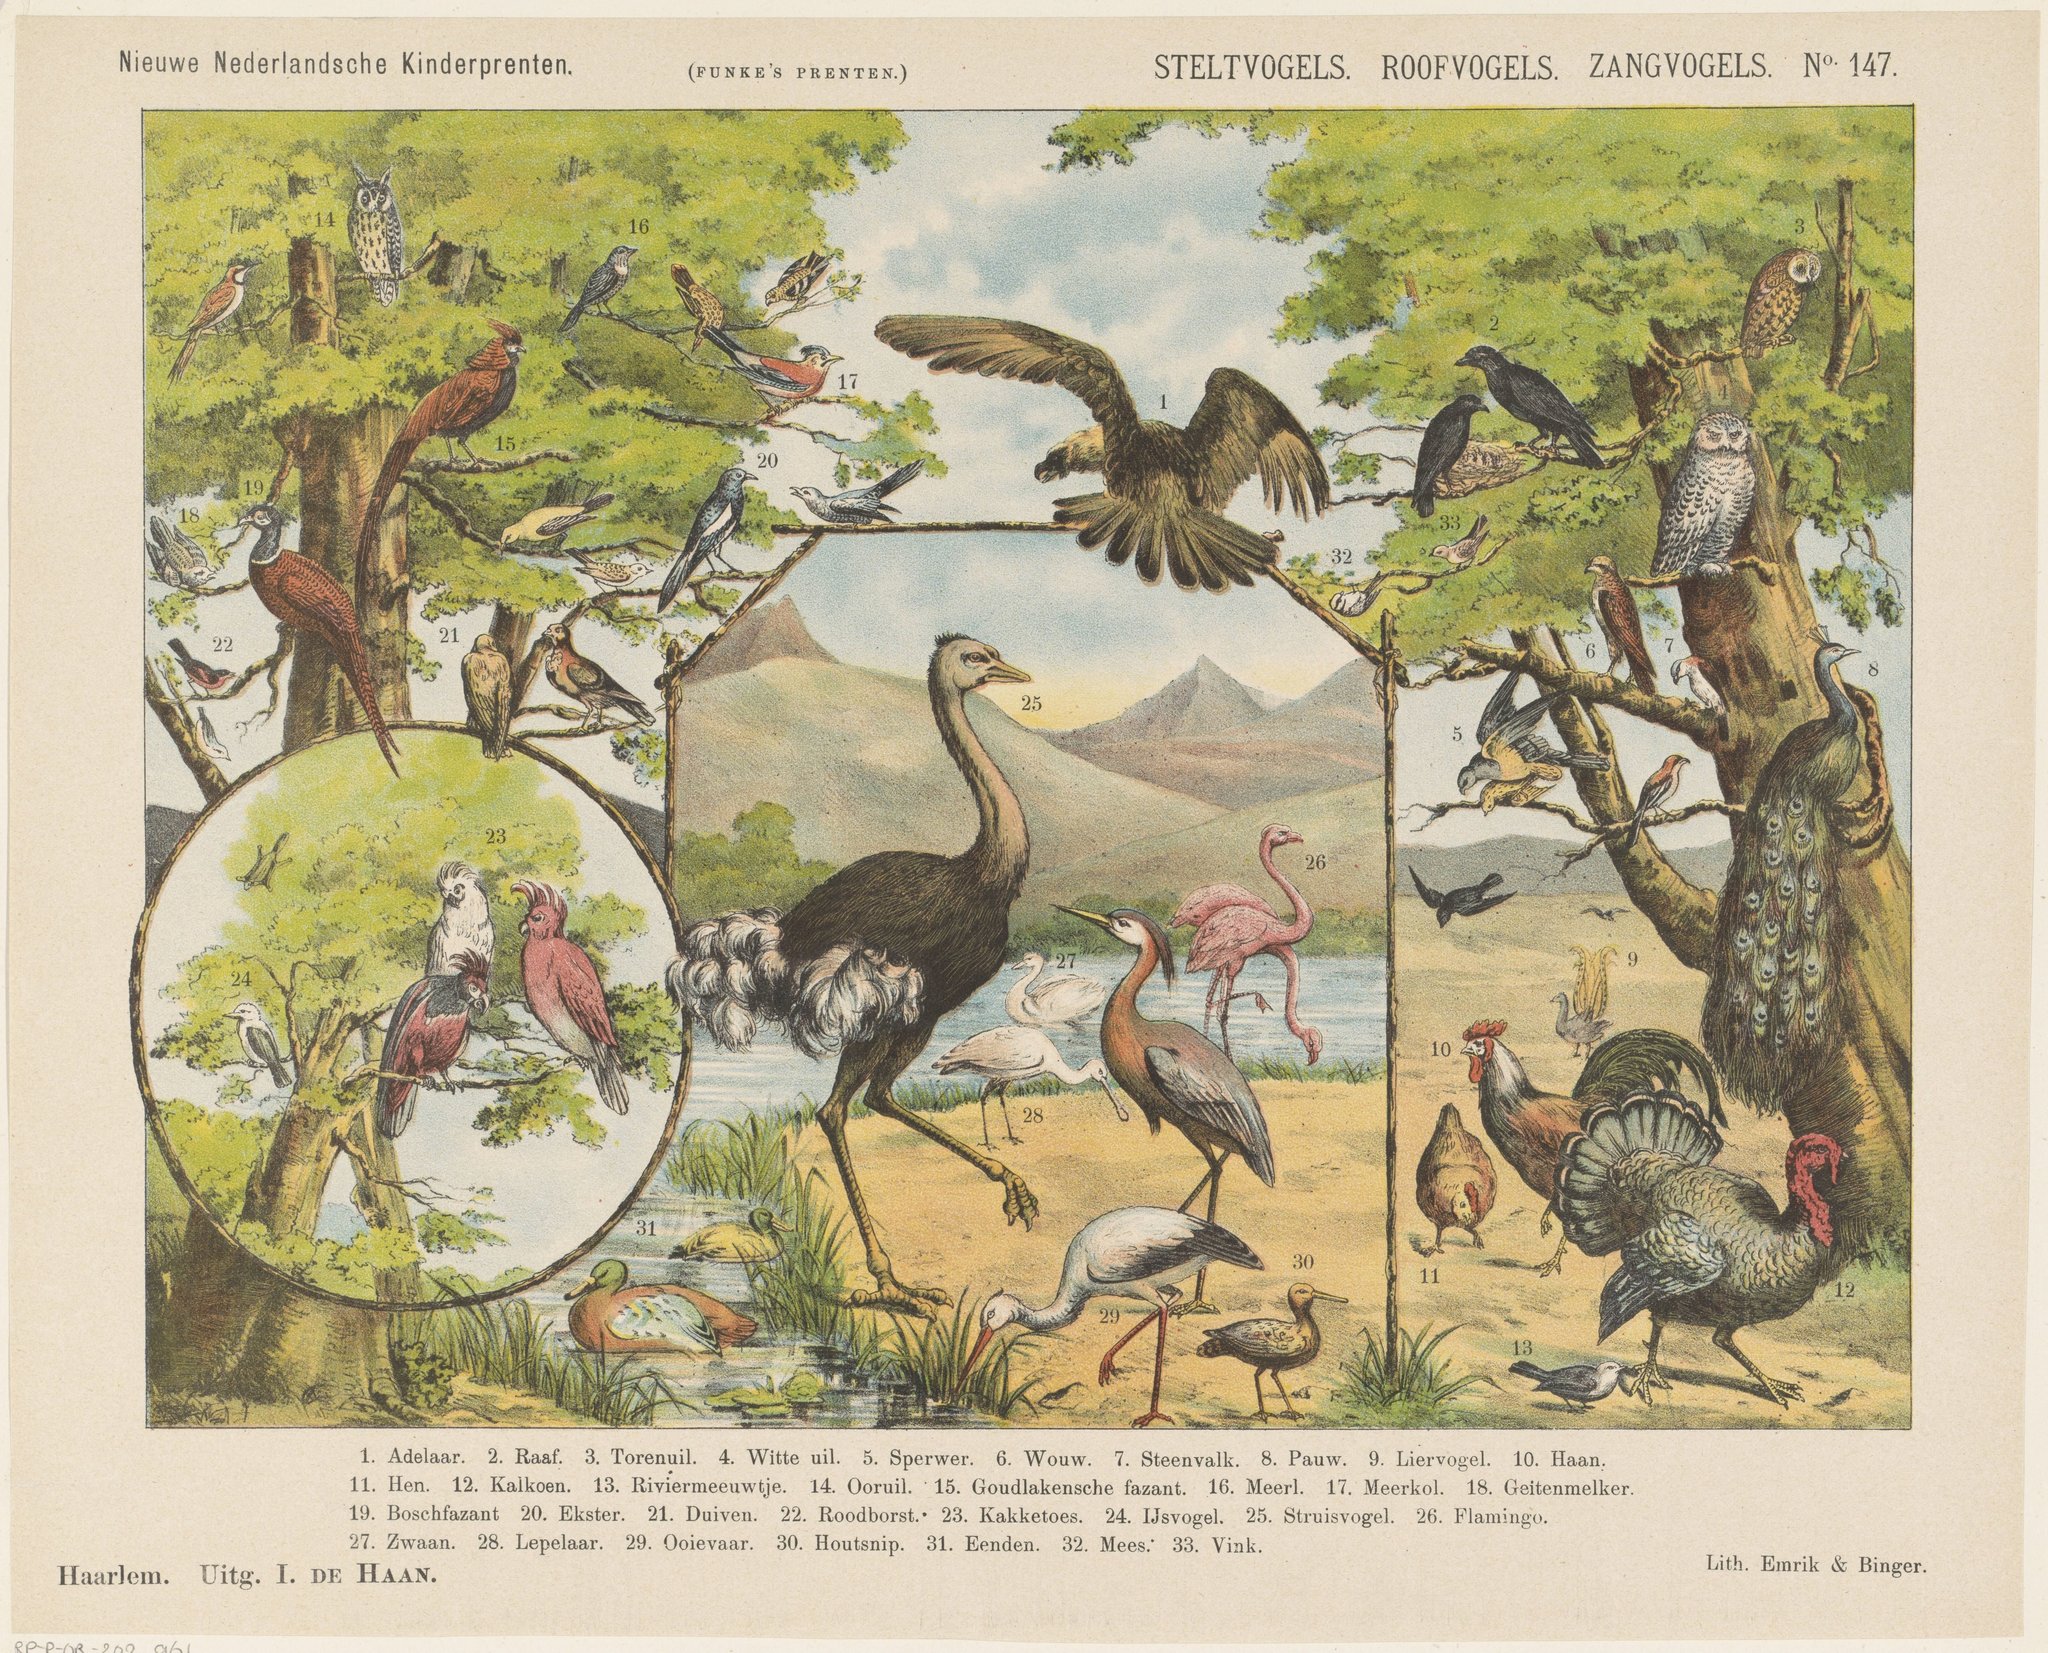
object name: popular print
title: Nieuwe Nederlandsche kinderprenten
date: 1875-1903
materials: paper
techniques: lithograph, letterpress printing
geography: haarlem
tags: birds, fowl (cock, hen, chicken, etc.)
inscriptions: collector's mark: Lugt 2760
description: Blad met 3 voorstellingen van in totaal 33 soorten vogels, zoals een adelaar, een struisvogel, flamingo's en een kalkoen. In de ondermarge een verklarende lijst met nummers. Genummerd rechtsboven: No. 147.